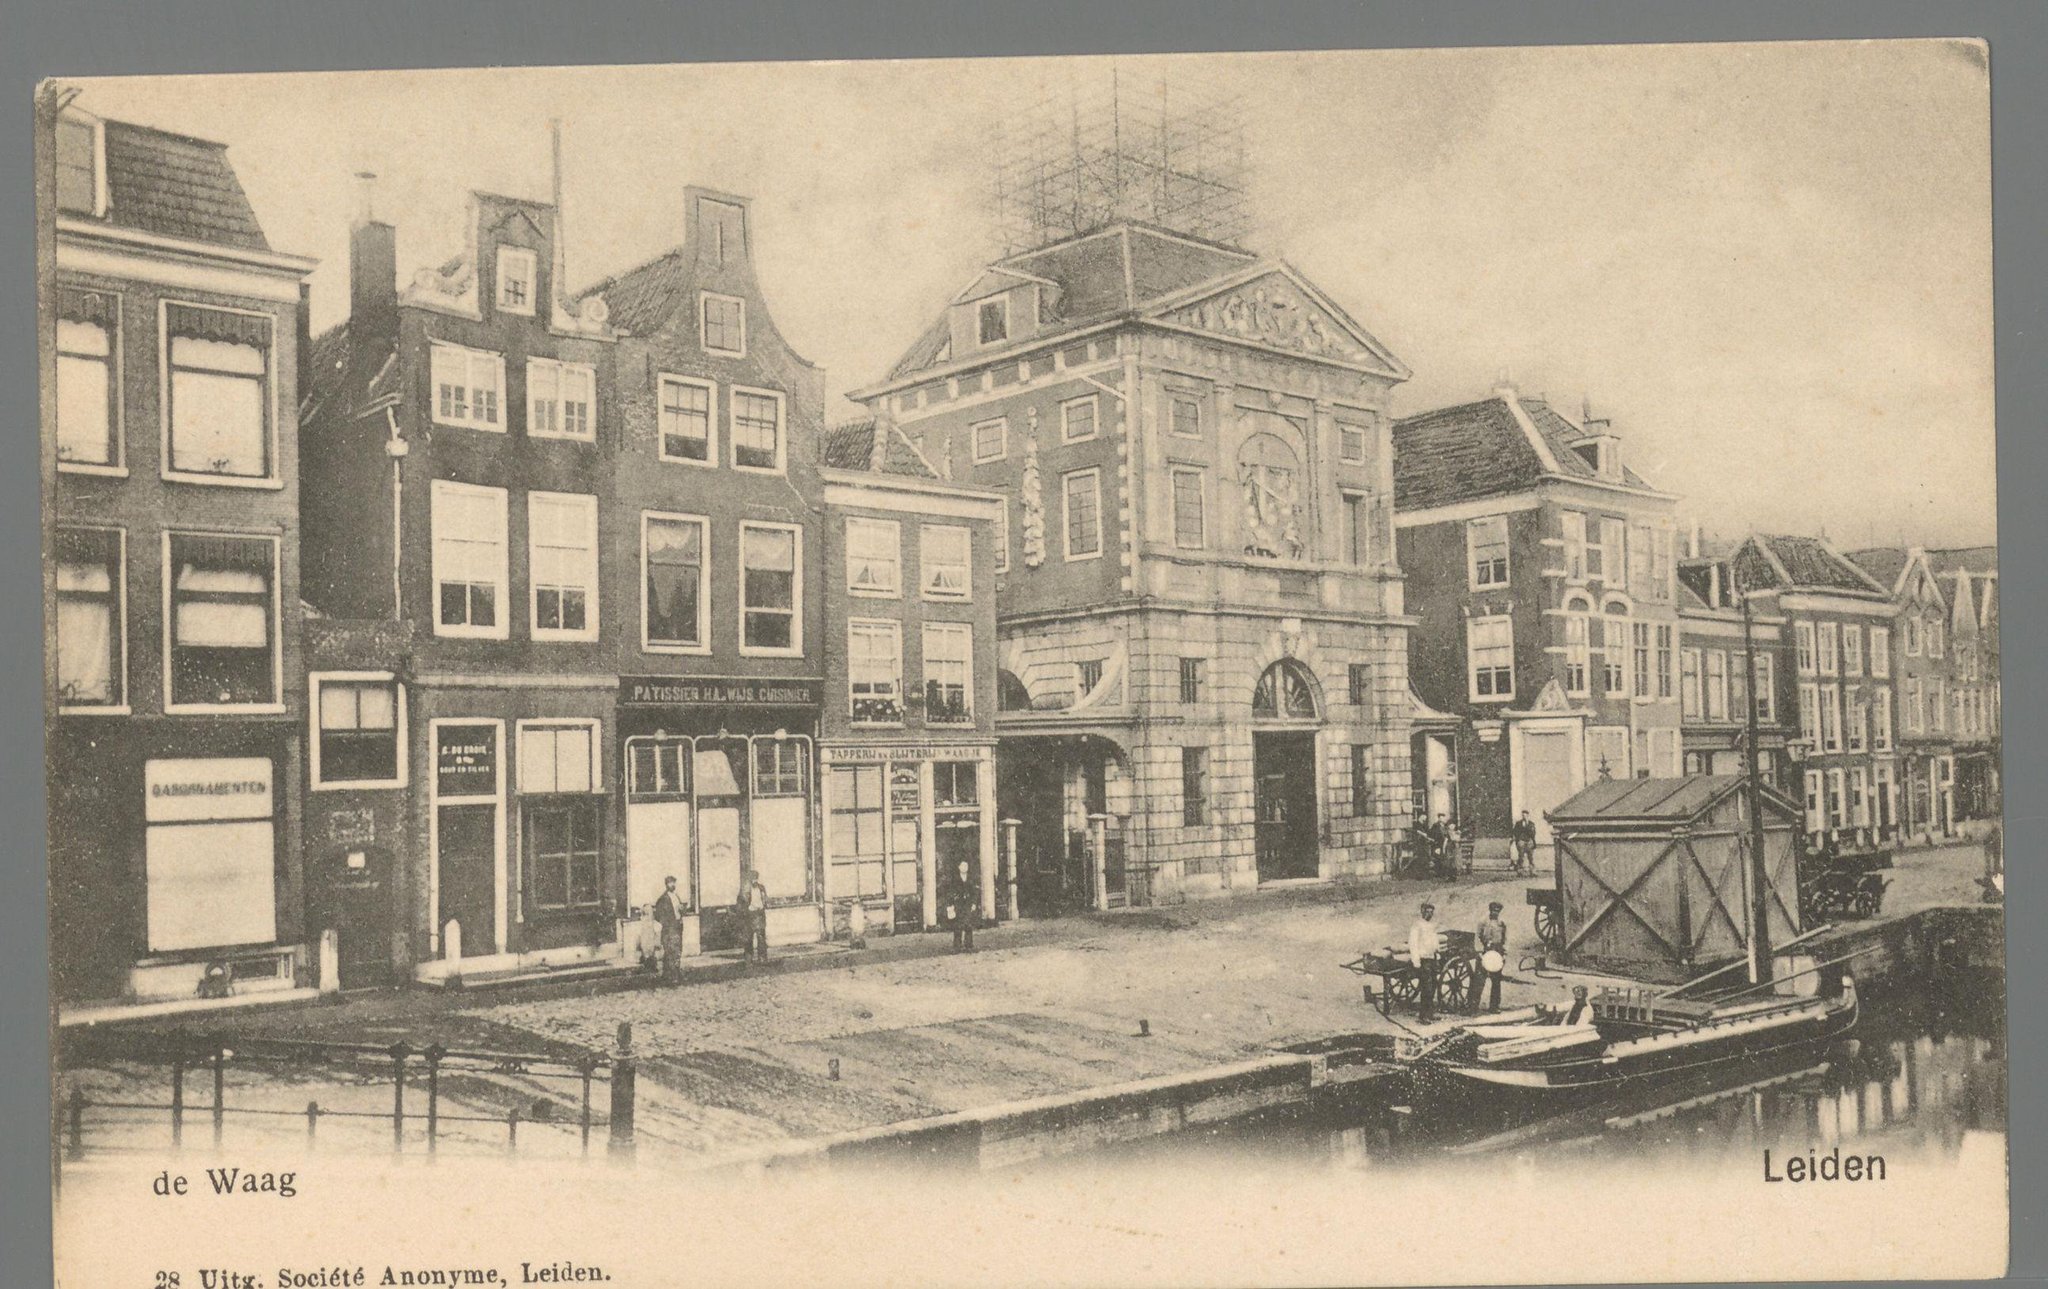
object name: ansichtkaart, prentbriefkaart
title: De Waag. Leiden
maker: Anonymous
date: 1897-1905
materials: cardboard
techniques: photograph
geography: leiden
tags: canal, street, weigh-house